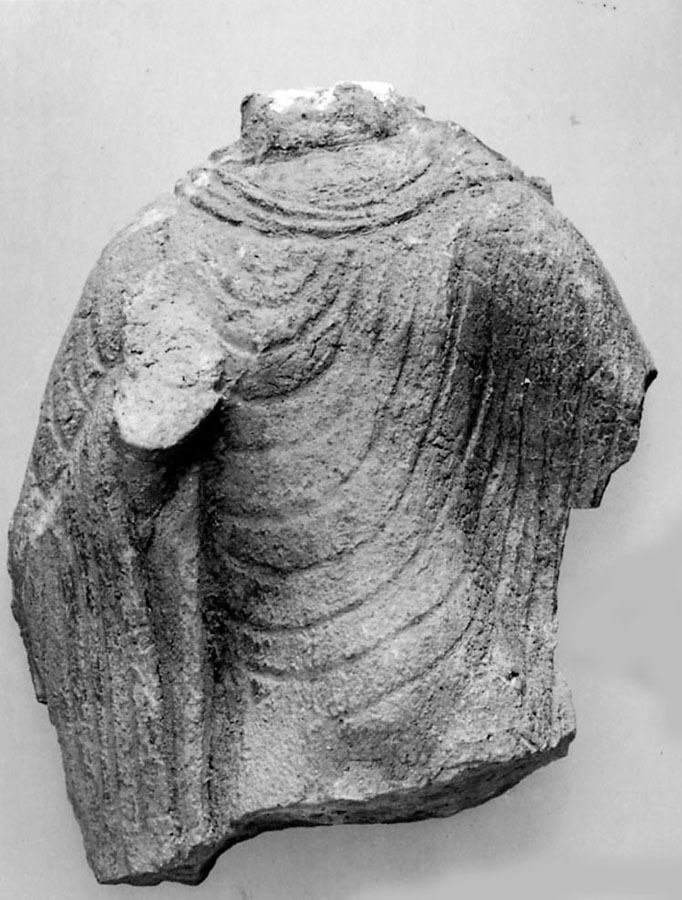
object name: relief fragment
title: Fragment of a Relief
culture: central asian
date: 201-700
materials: plaster